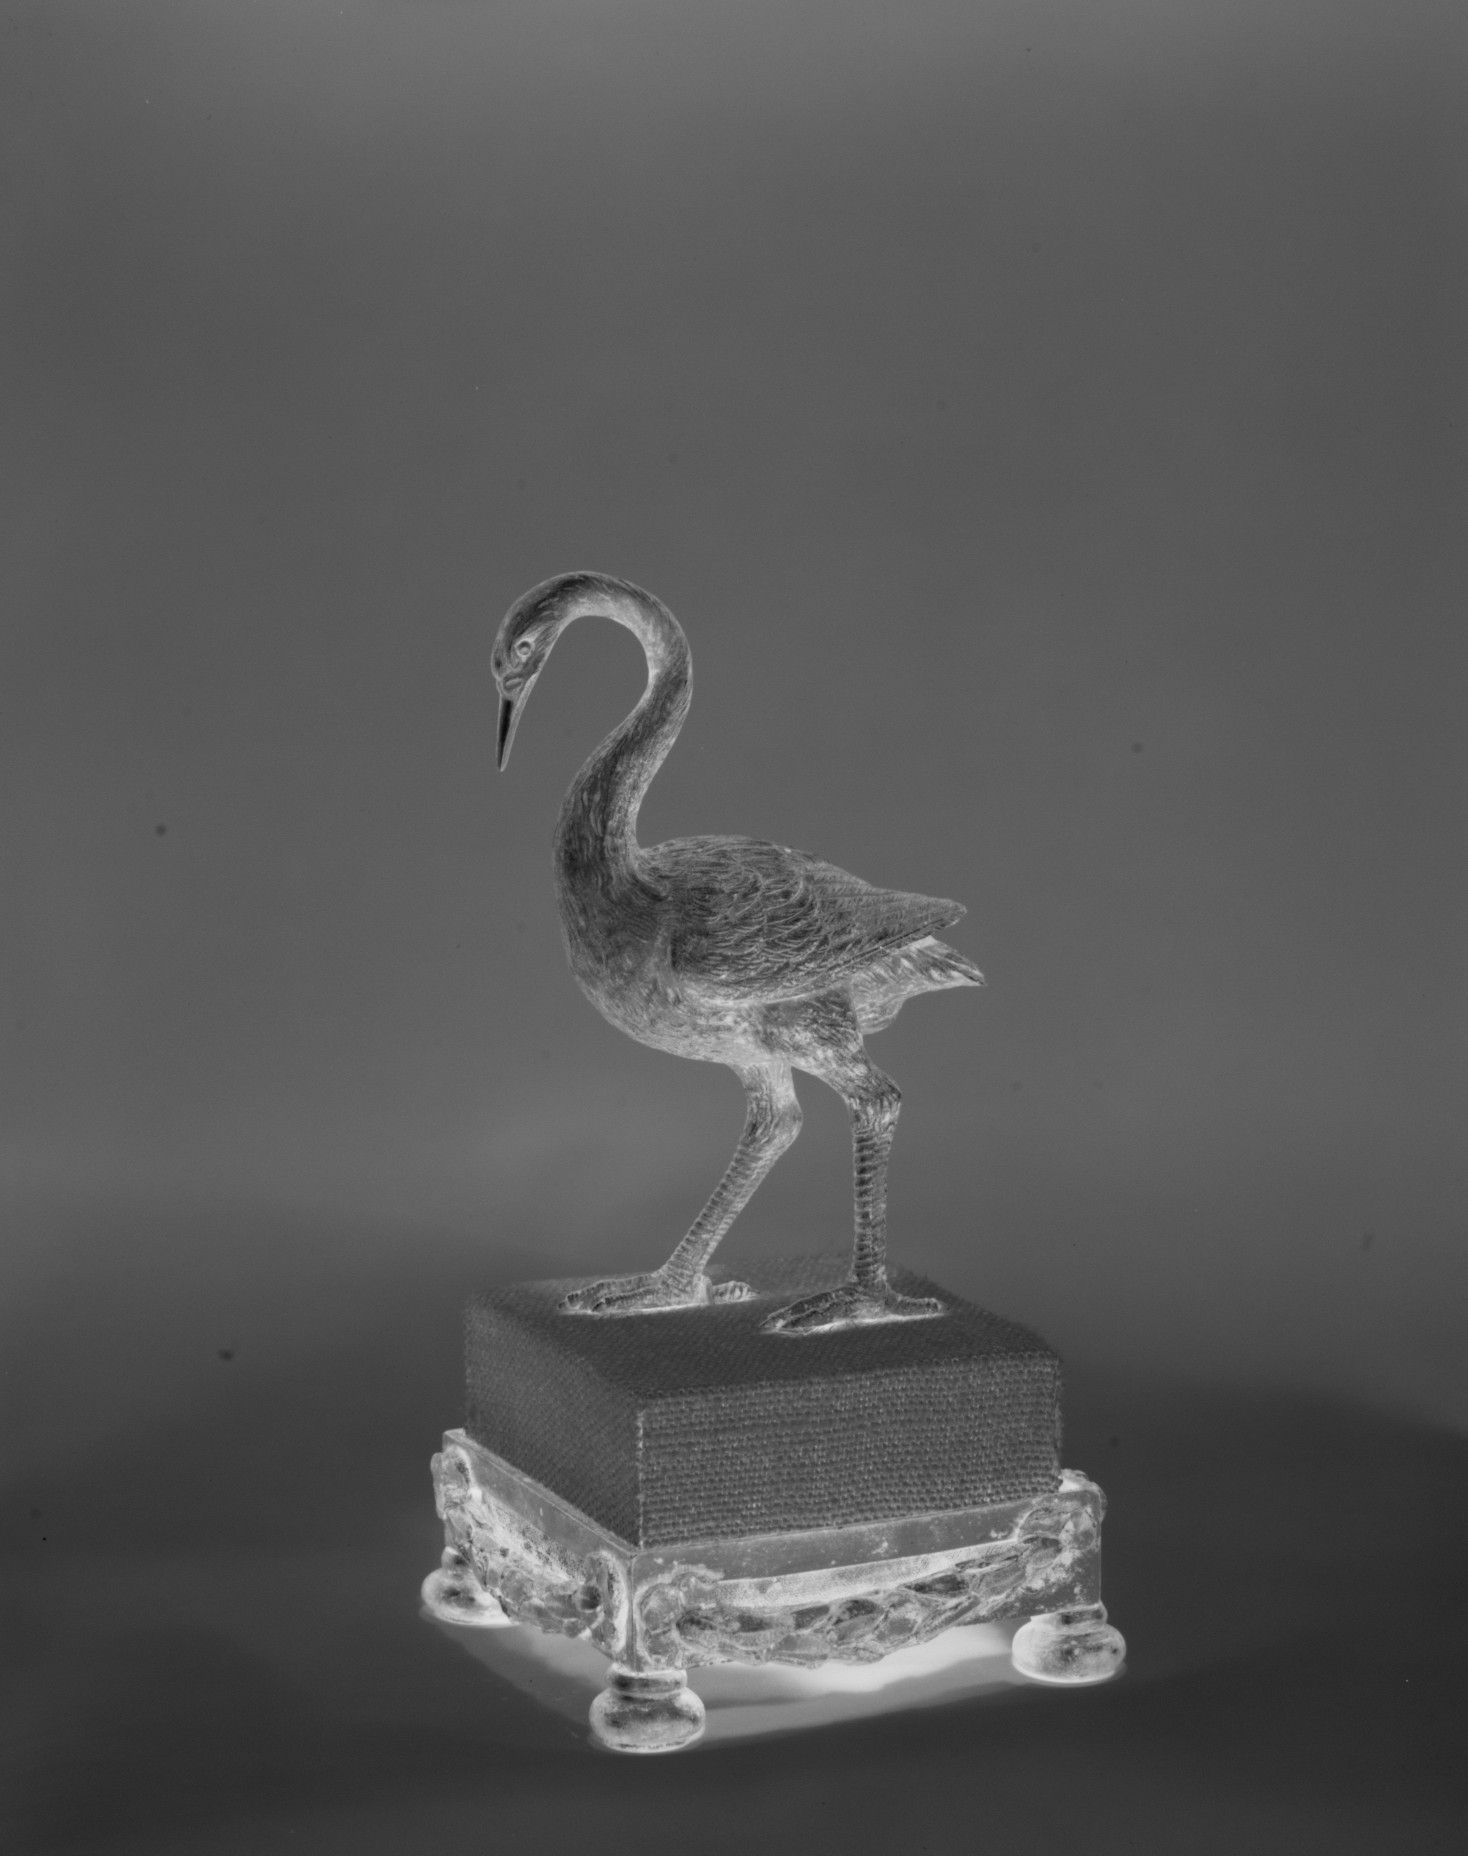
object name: base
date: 1701-1800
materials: gilt bronze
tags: swans